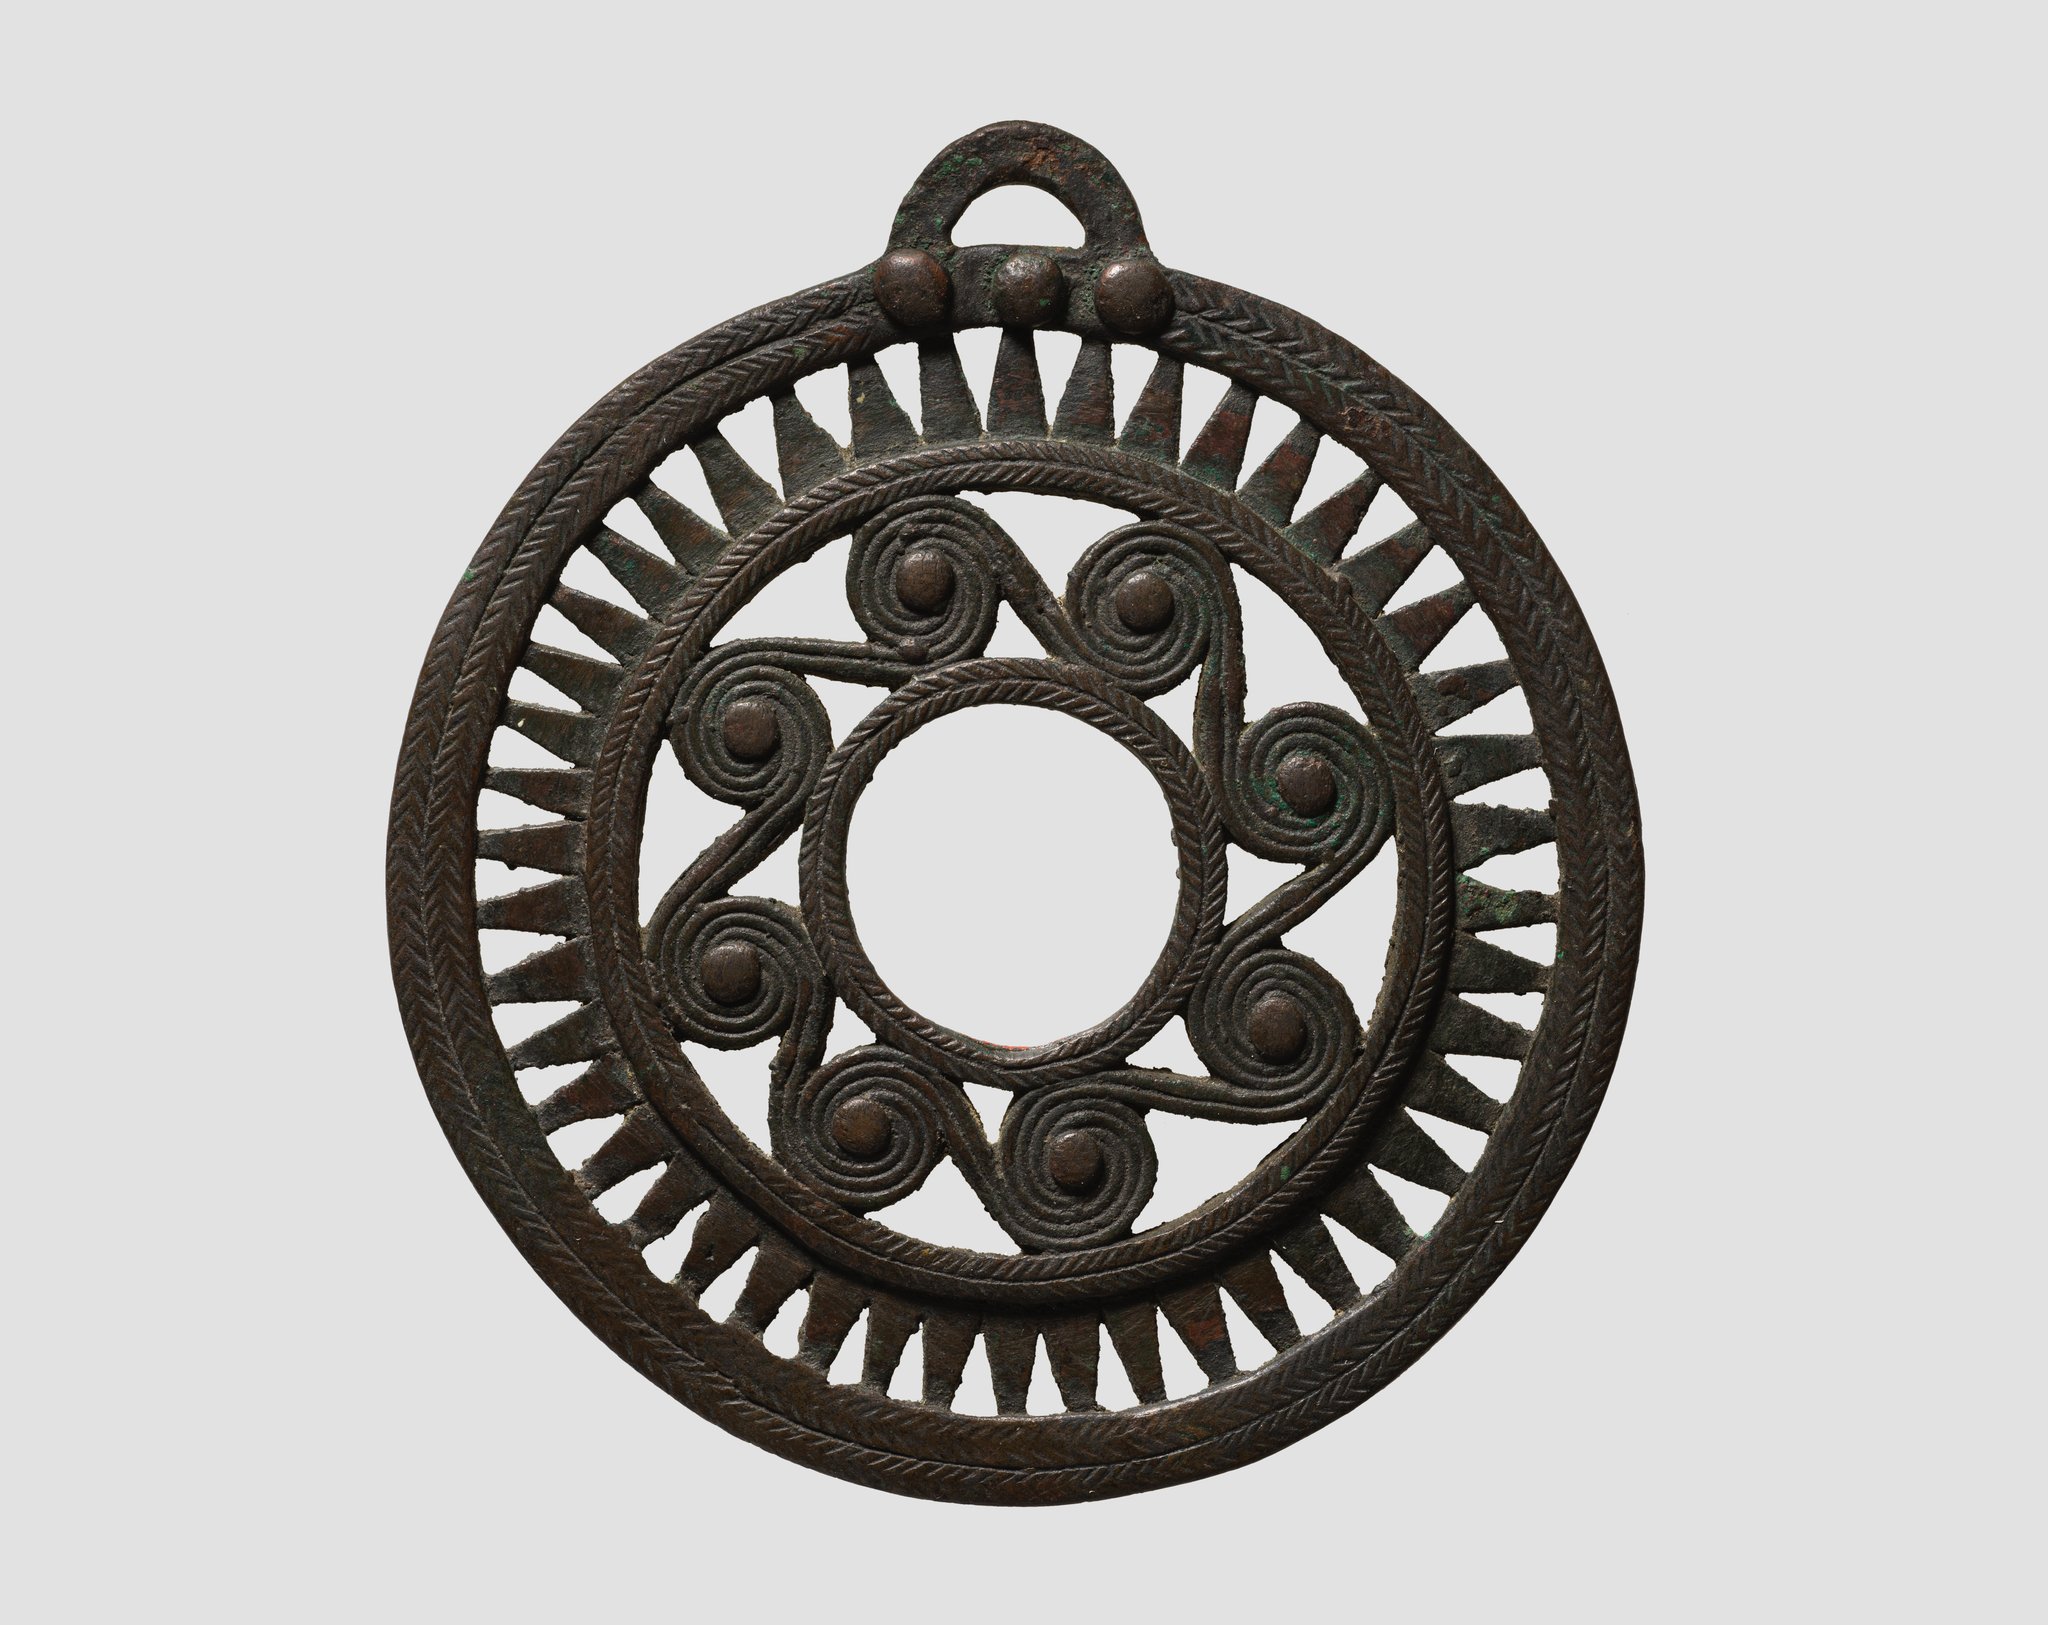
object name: pendant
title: Openwork pendant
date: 1-200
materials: bronze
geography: transcaucasia